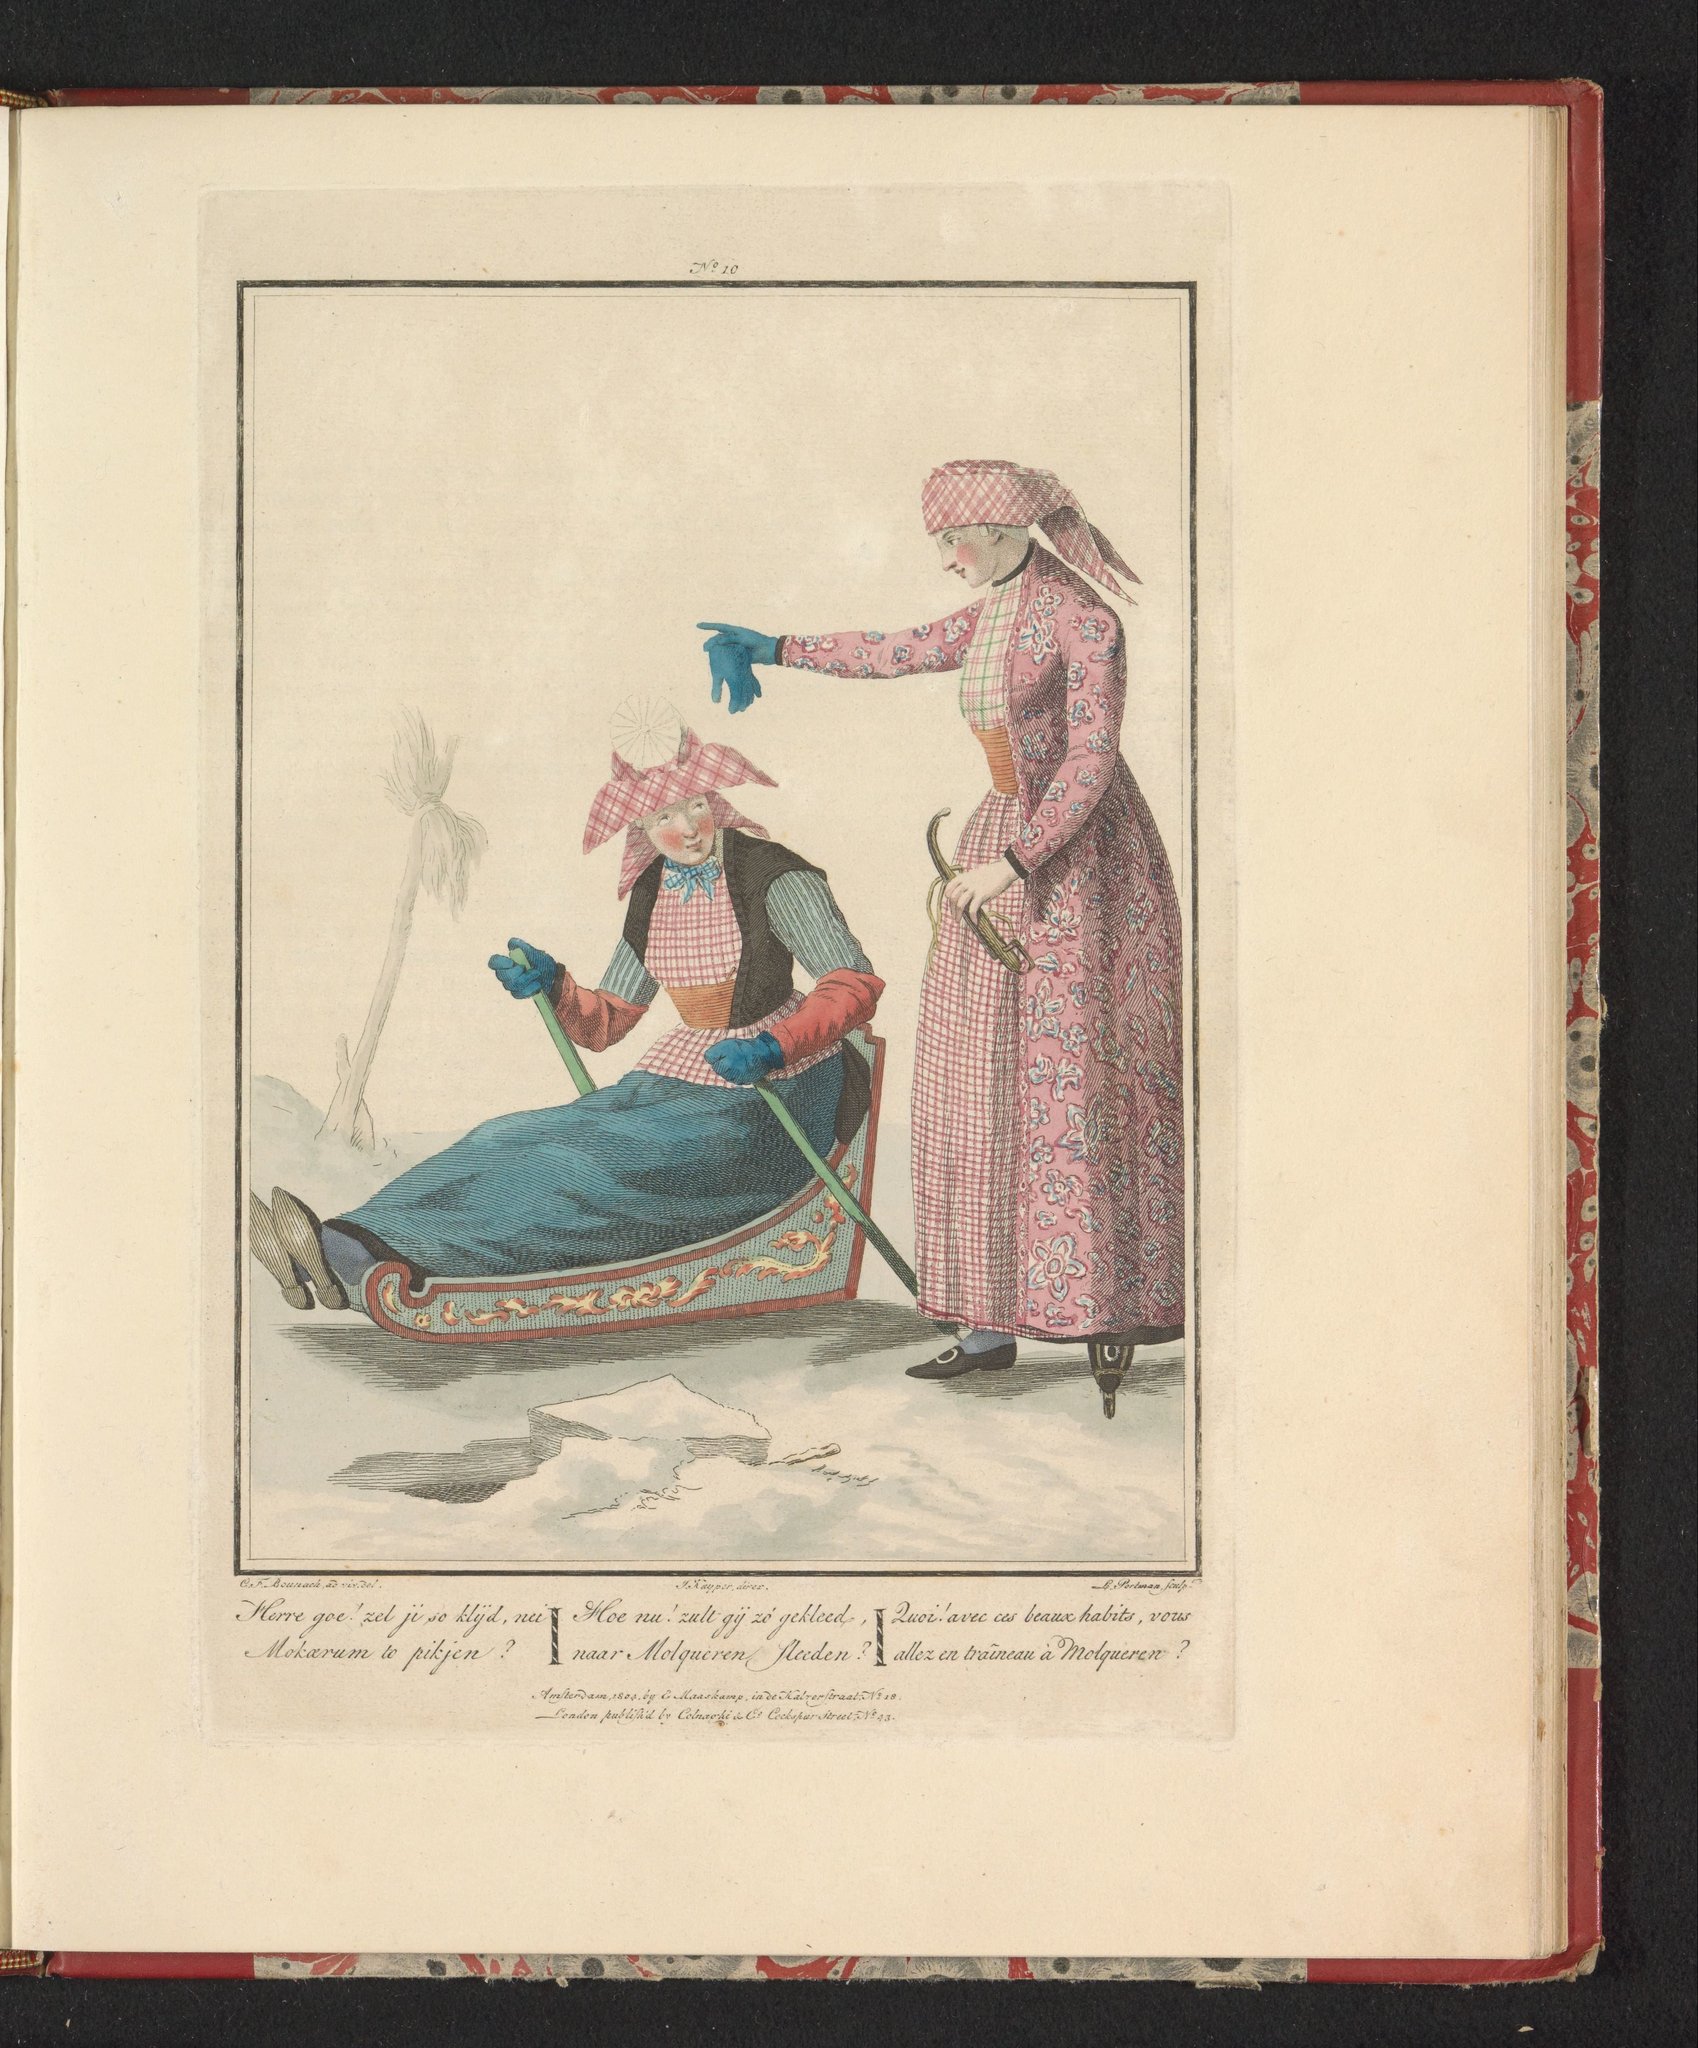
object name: print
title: Herre goe! zel ji so klijd, nu Mokœrum te pikjen? / Hoe nu! zult gij zó gekleed, naar Molqueren Sleeden? / Quoi! avec ces beaux habits, vous allez en traîneau à Molqueren?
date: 1804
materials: paper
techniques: etching, hand coloring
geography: london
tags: skates (winter sports), folk costume, regional costume, clothes, costume, small sleigh (winter sports)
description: Twee jongedames in Friese klederdracht op het ijs. De een zit in een slee, de andere staat op de schaats. Uit Hindeloopen of een plaats in de buurt. Derde aflevering van vier platen, verschenen in 1804. Onderdeel van een gebonden uitgave van de reeks van twintig platen van Nederlandse klederdrachten in de Bataafse Republiek aan het begin van de negentiende eeuw door Maaskamp, ca. 1807.